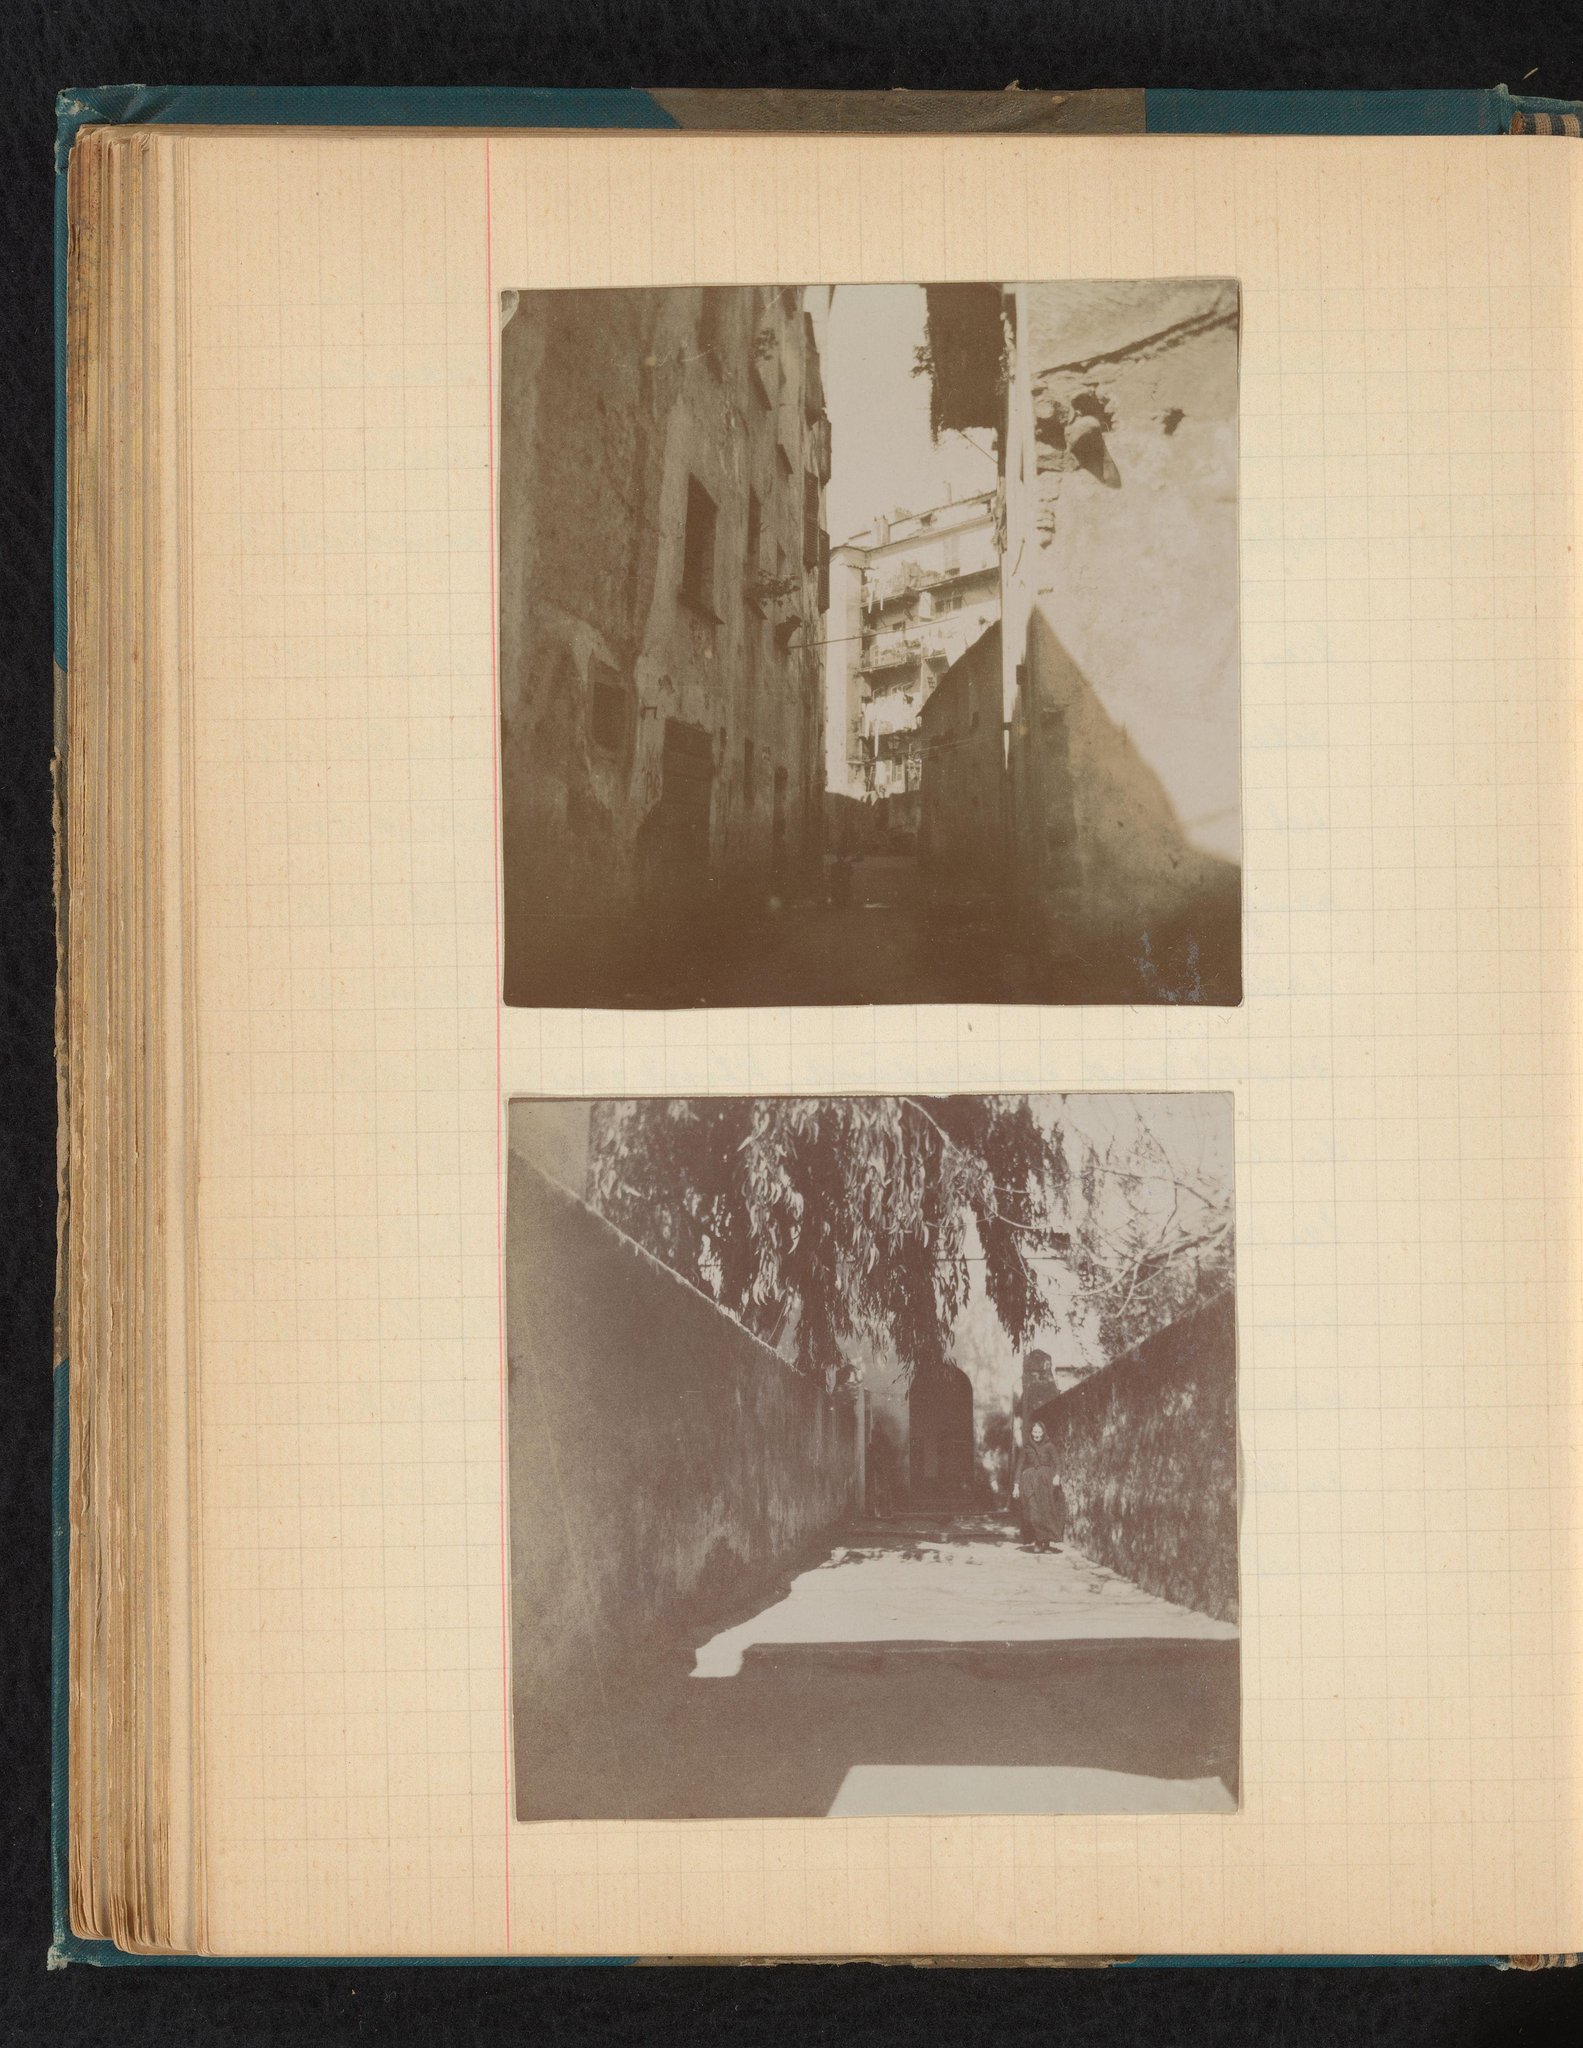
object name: album leaf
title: Straatgezicht en een ommuurde trap richting de ingang van een gebouw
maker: théodore van lelyveld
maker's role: painter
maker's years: 1867-1954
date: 1902-1904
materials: paper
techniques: daylight paper print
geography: ajaccio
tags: sloping street; street with steps or stairs, fence, wall, paling, front steps, street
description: Deze foto's maken deel uit van een album.